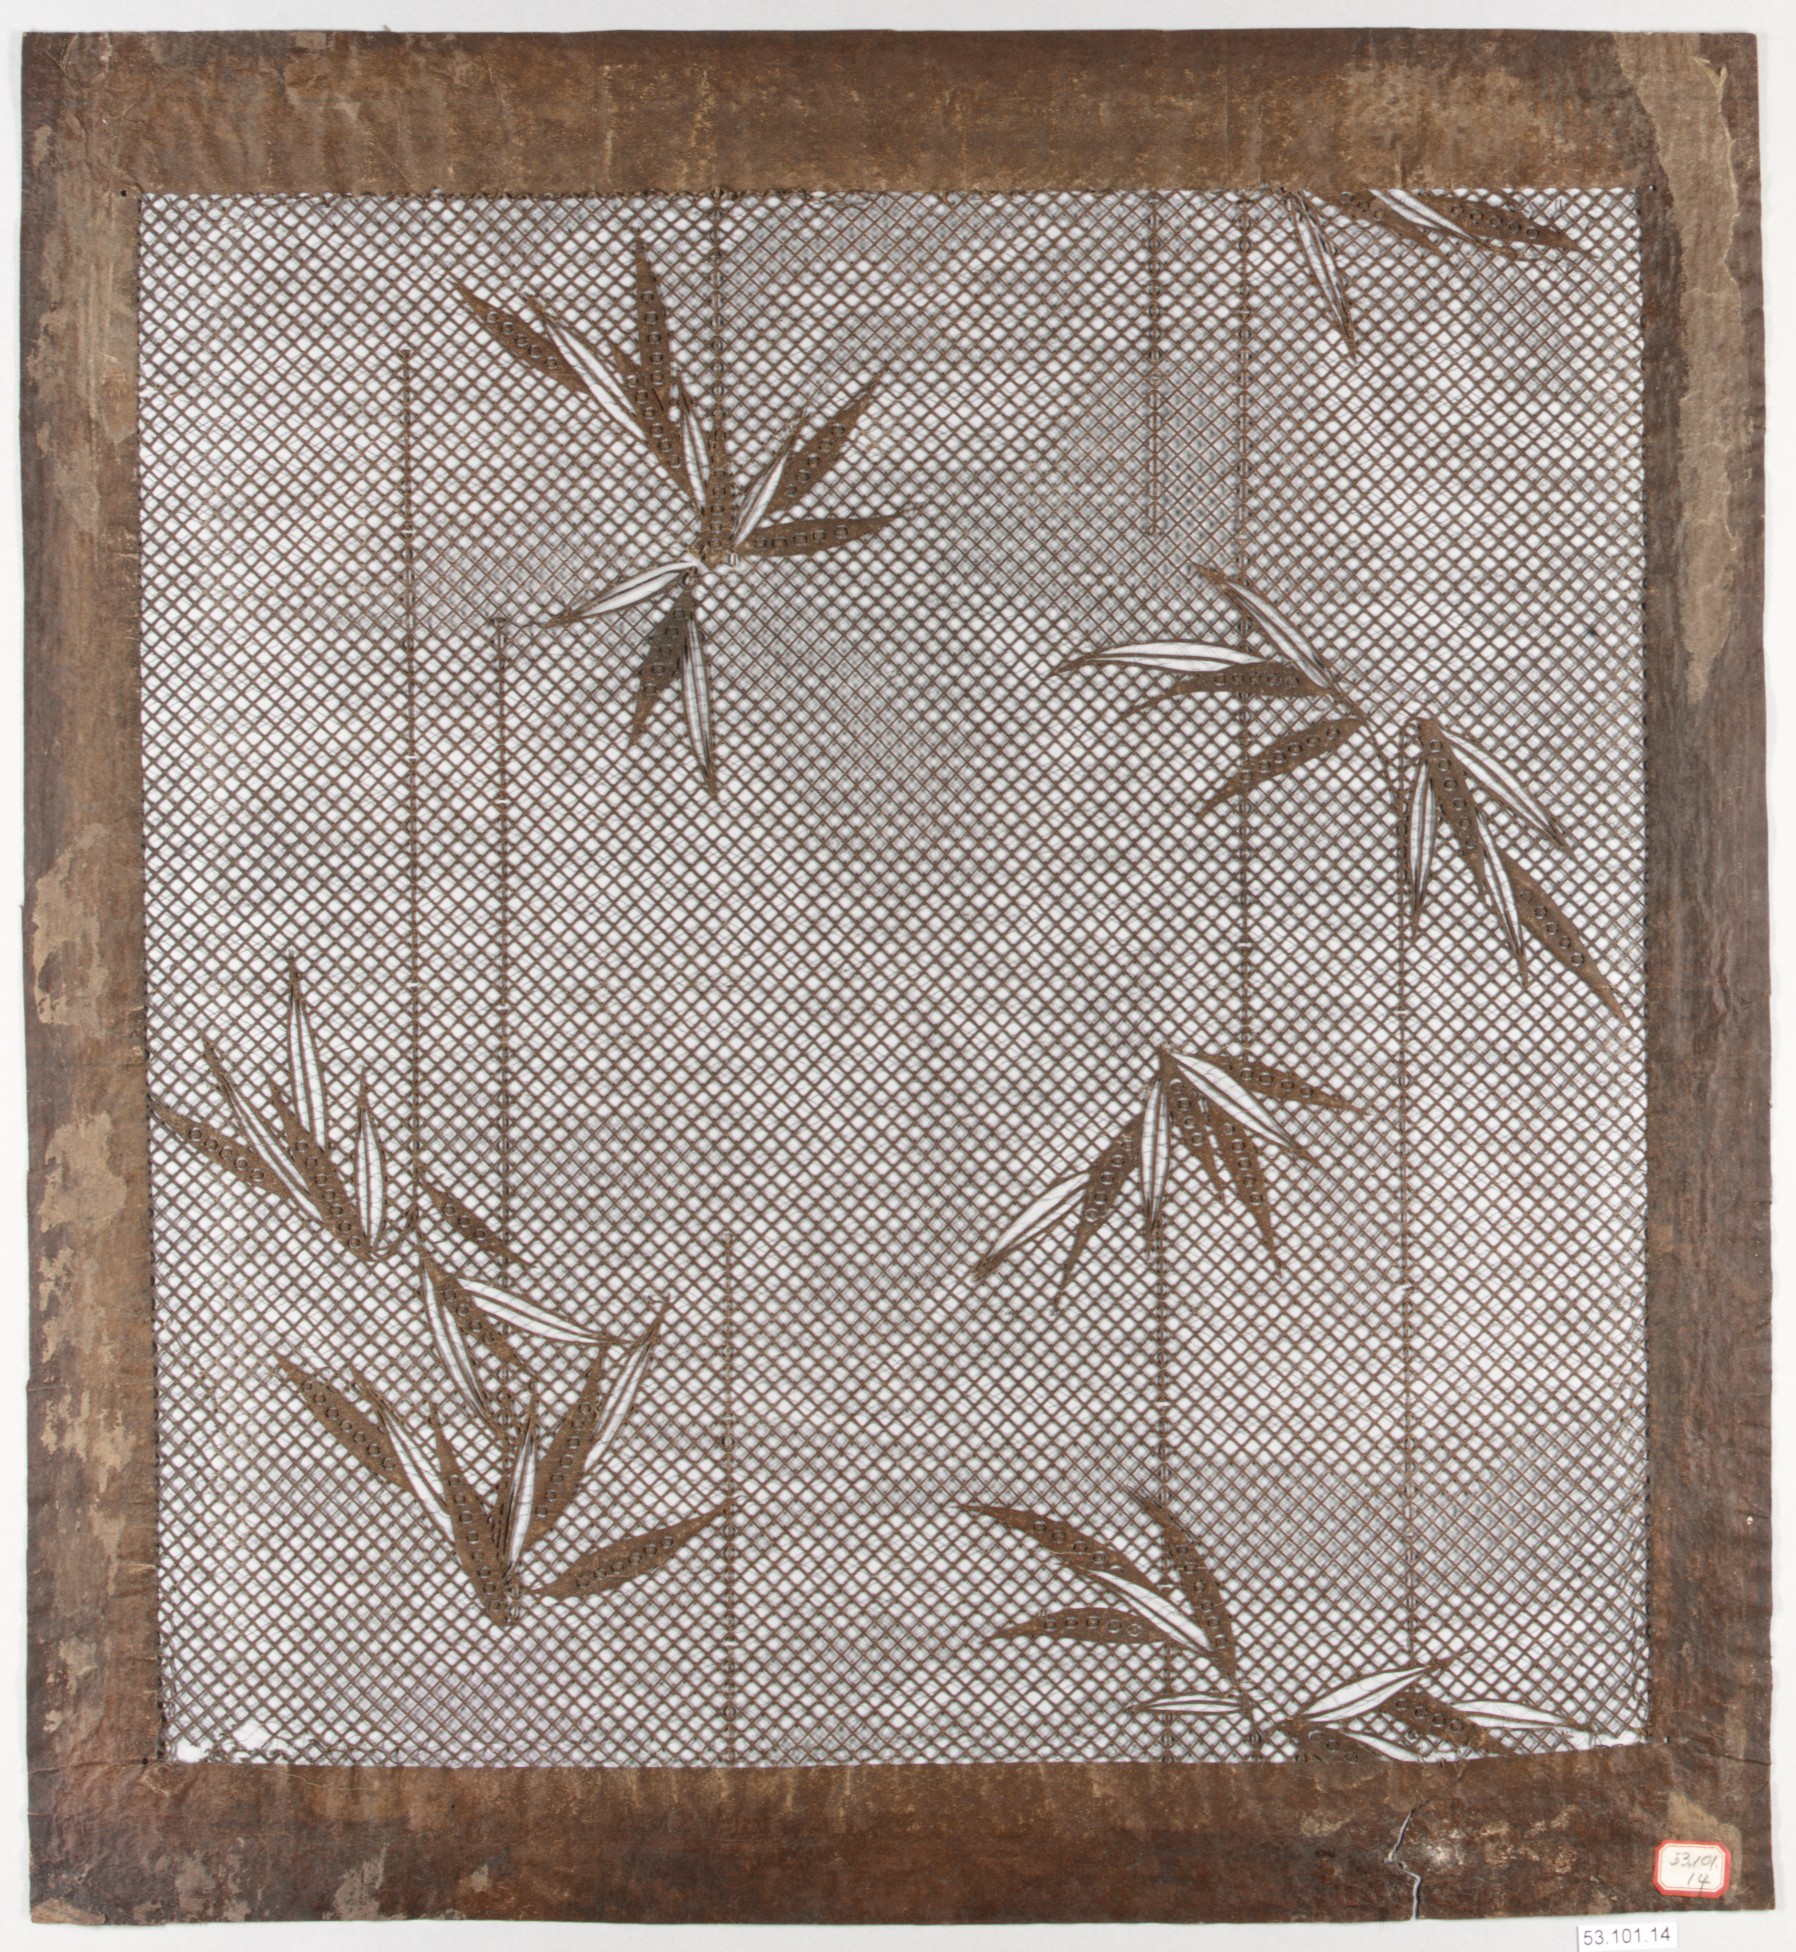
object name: stencil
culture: japanese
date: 1615-1868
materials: paper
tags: leaves